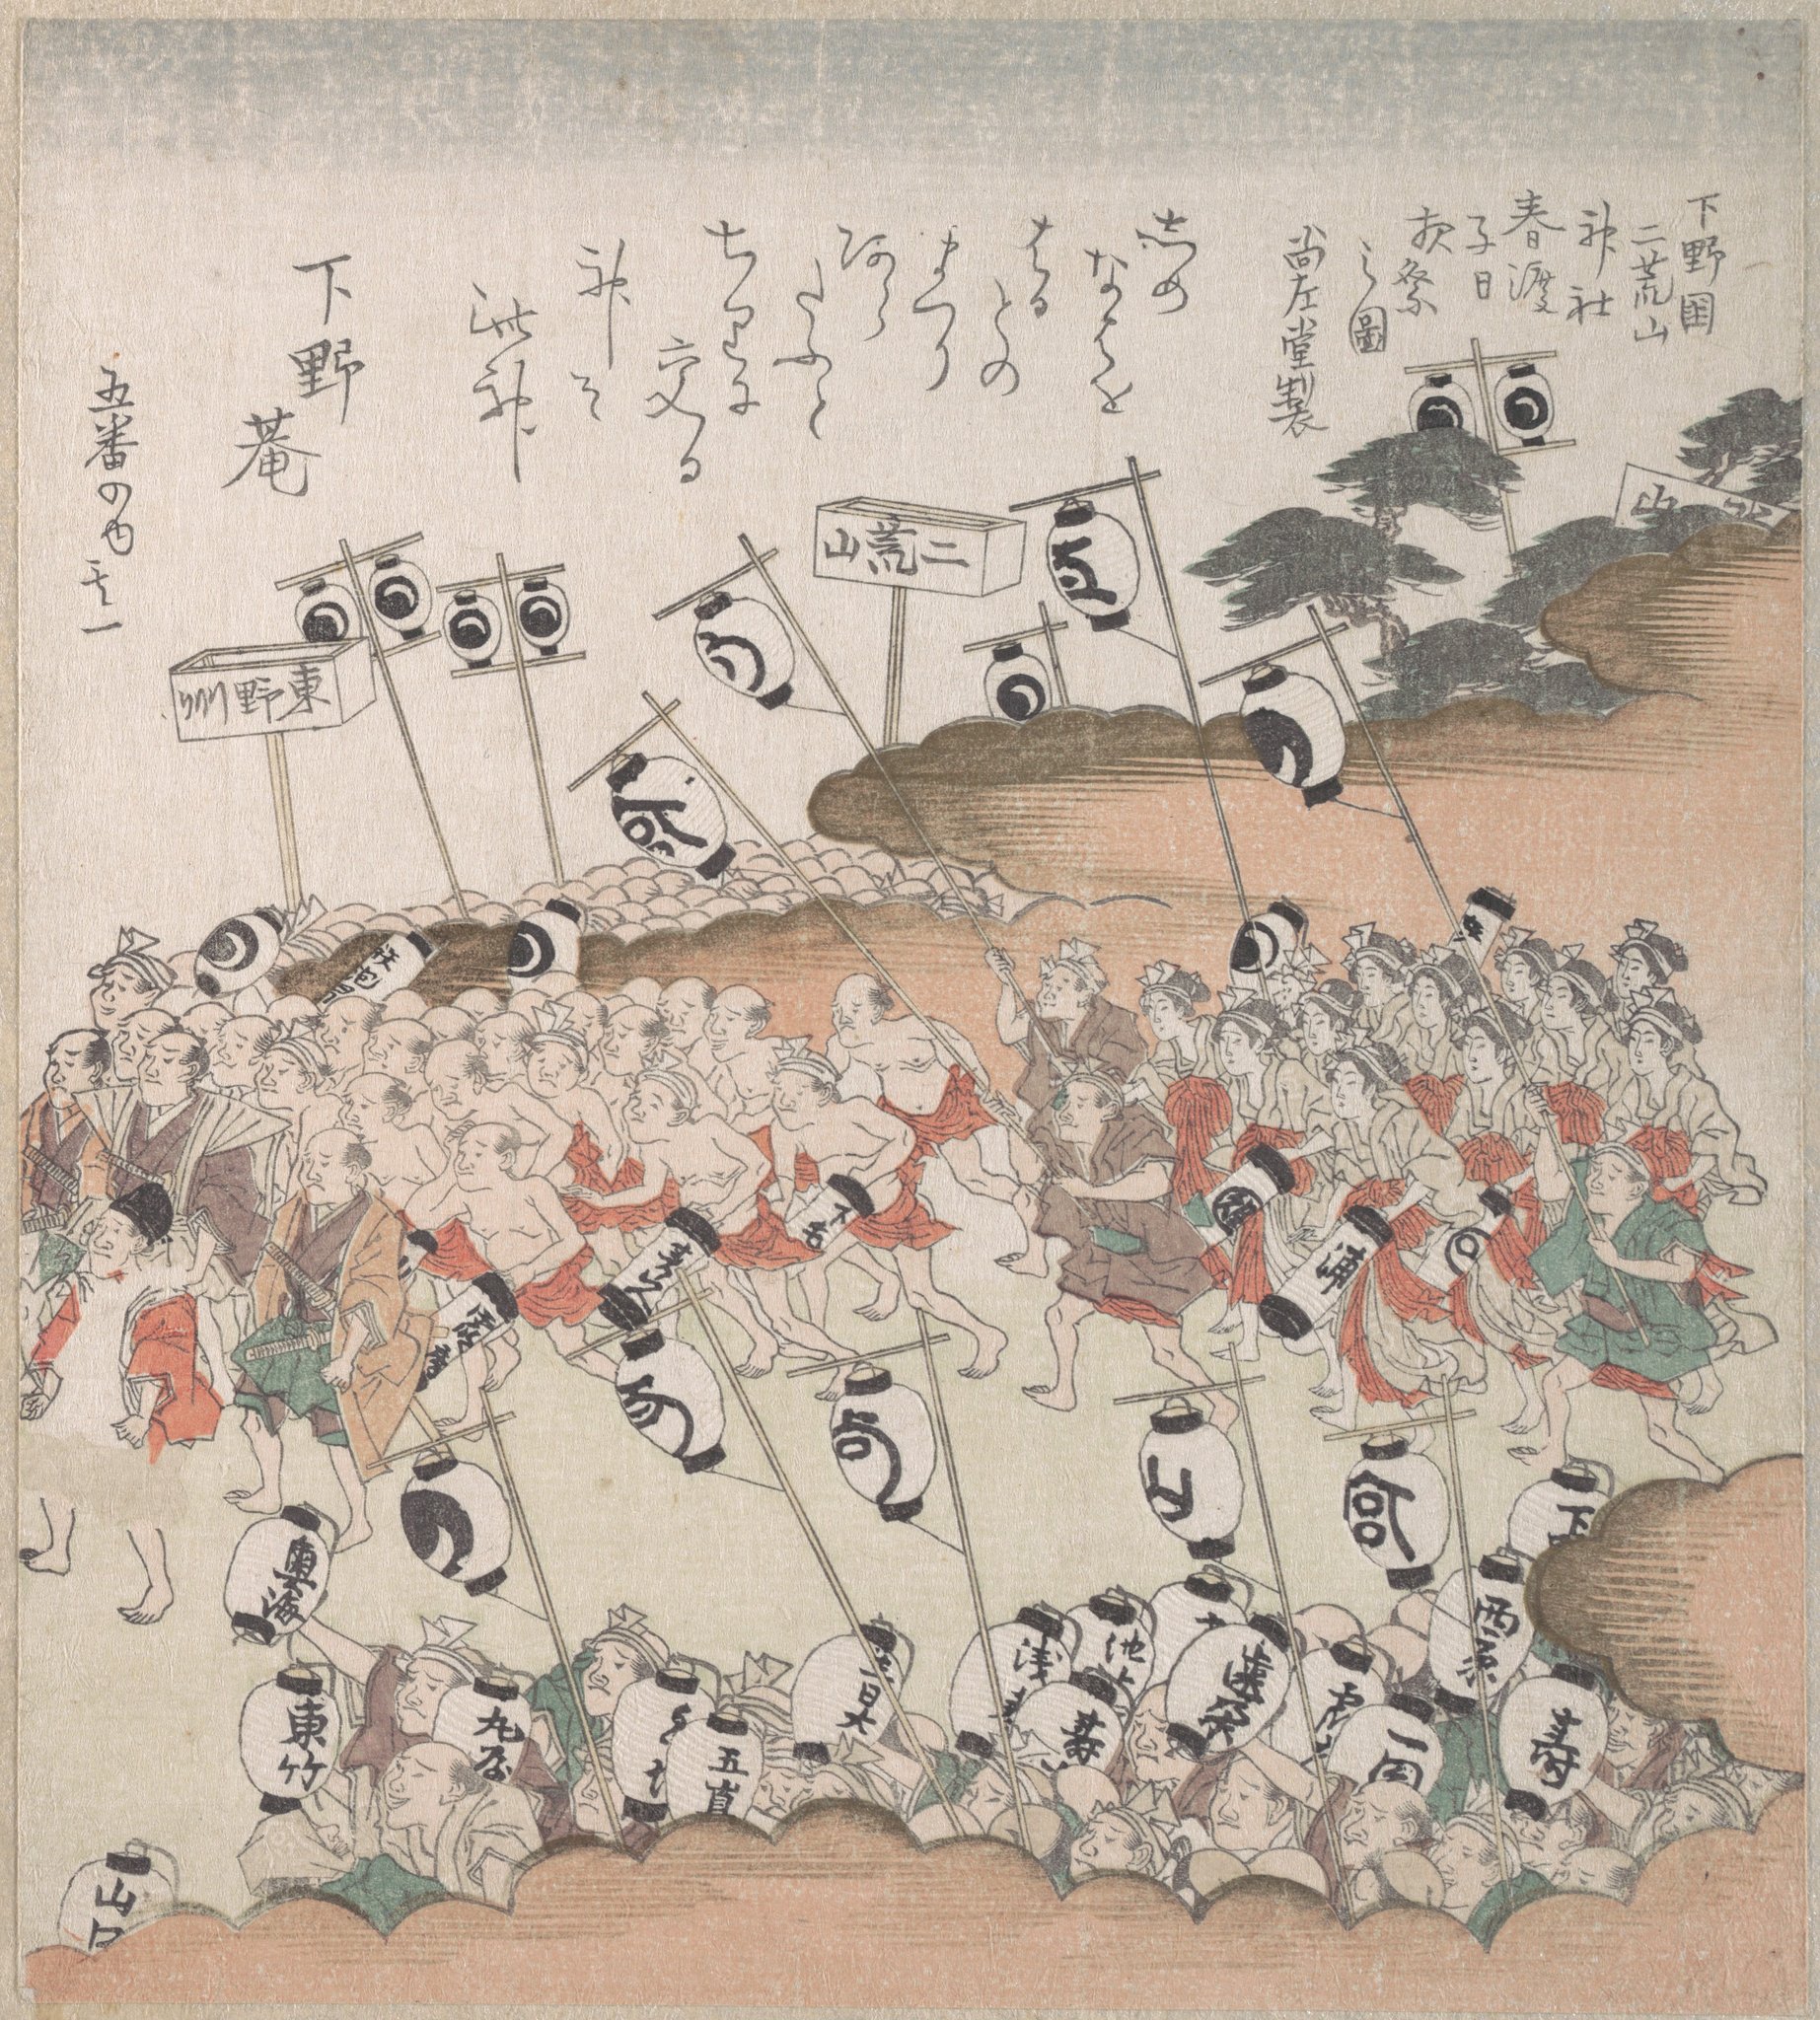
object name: print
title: People with Lanterns in Procession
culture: japanese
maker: kubo shunman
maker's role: artist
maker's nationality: japanese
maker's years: 1757-1820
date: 1801-1900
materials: ink, paper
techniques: surimono, woodblock print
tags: men,women,lanterns,processions